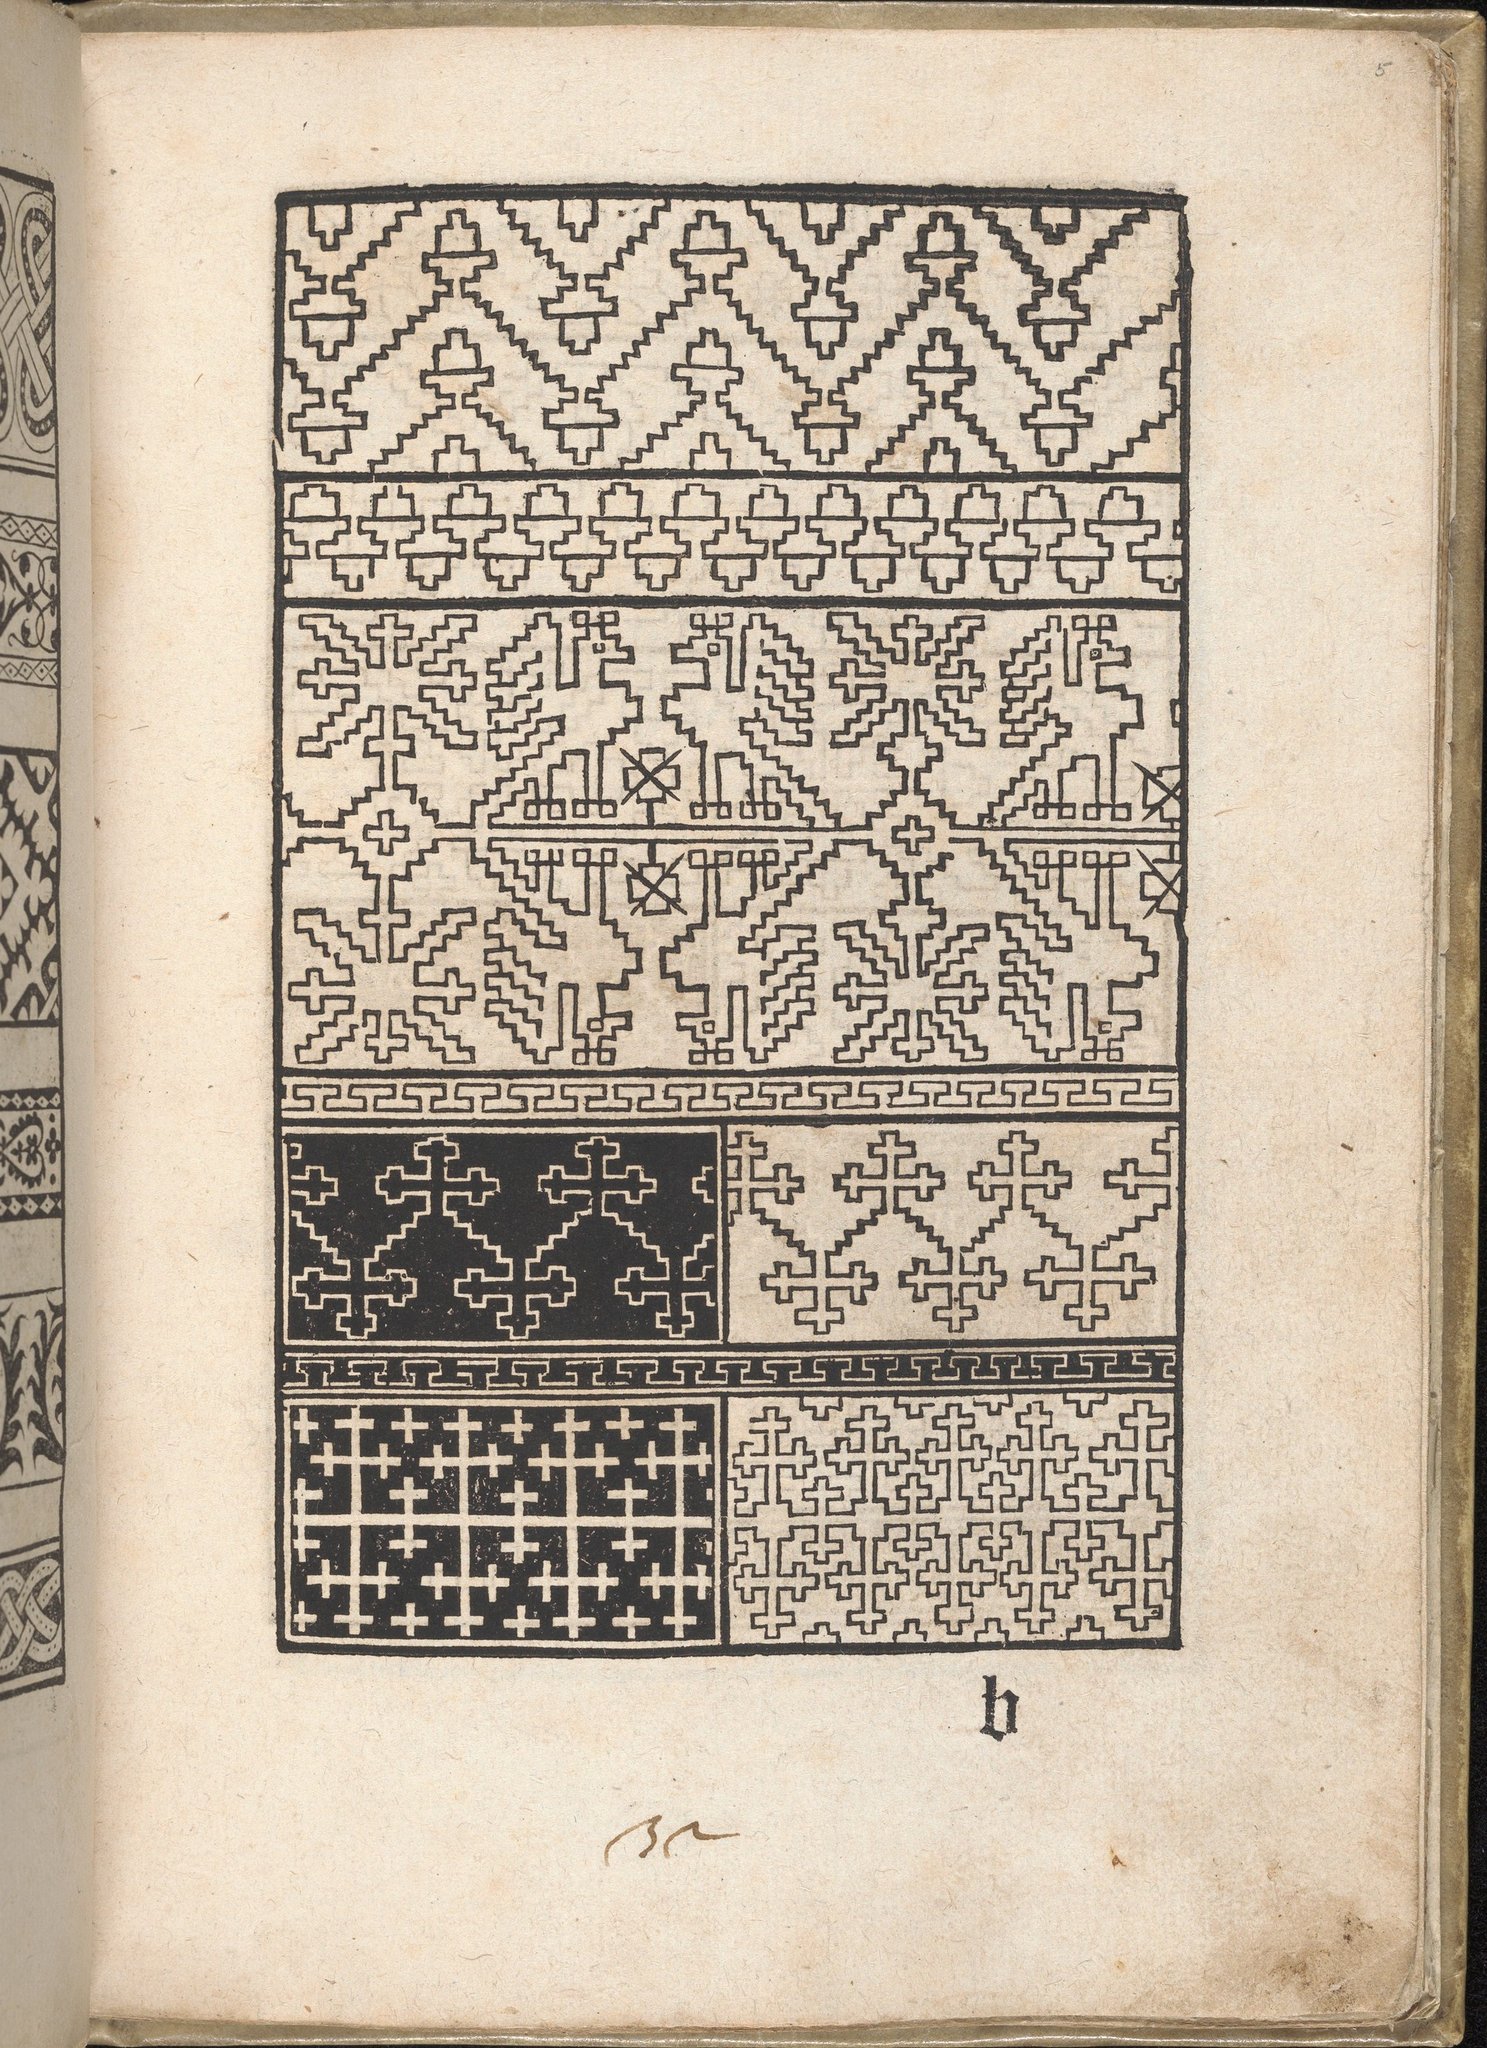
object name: book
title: Page 5v, from "Eyn New Kunstlichboich"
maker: peter quentel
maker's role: publisher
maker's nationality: german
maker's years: 1500-1550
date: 1529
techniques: woodcut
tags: birds